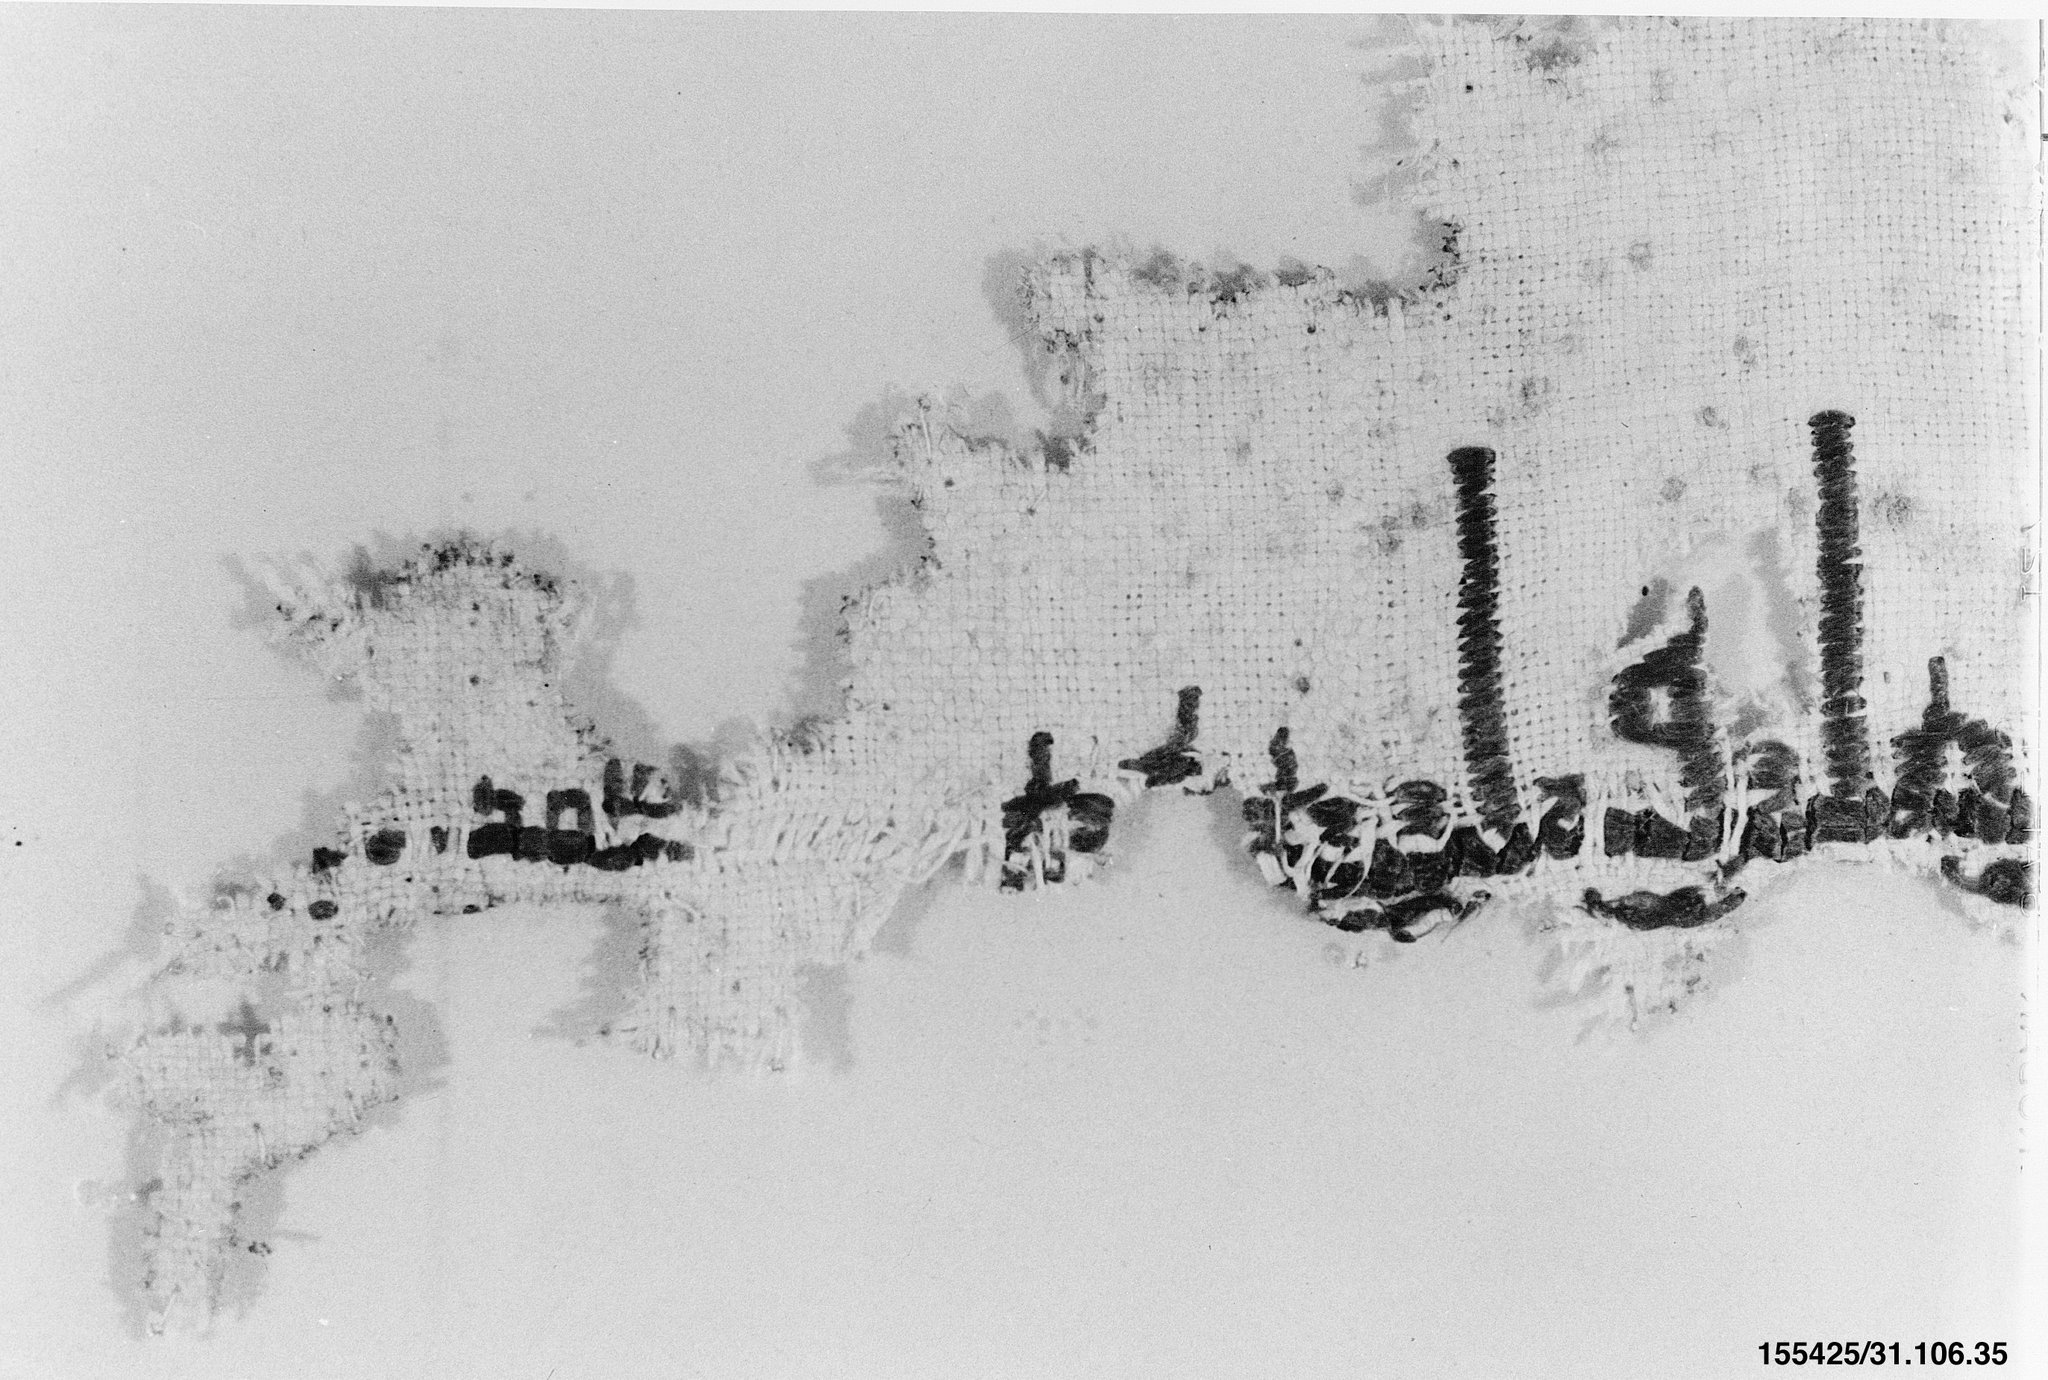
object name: textile fragment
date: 901-1000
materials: linen, silk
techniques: embroidery, weave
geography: egypt